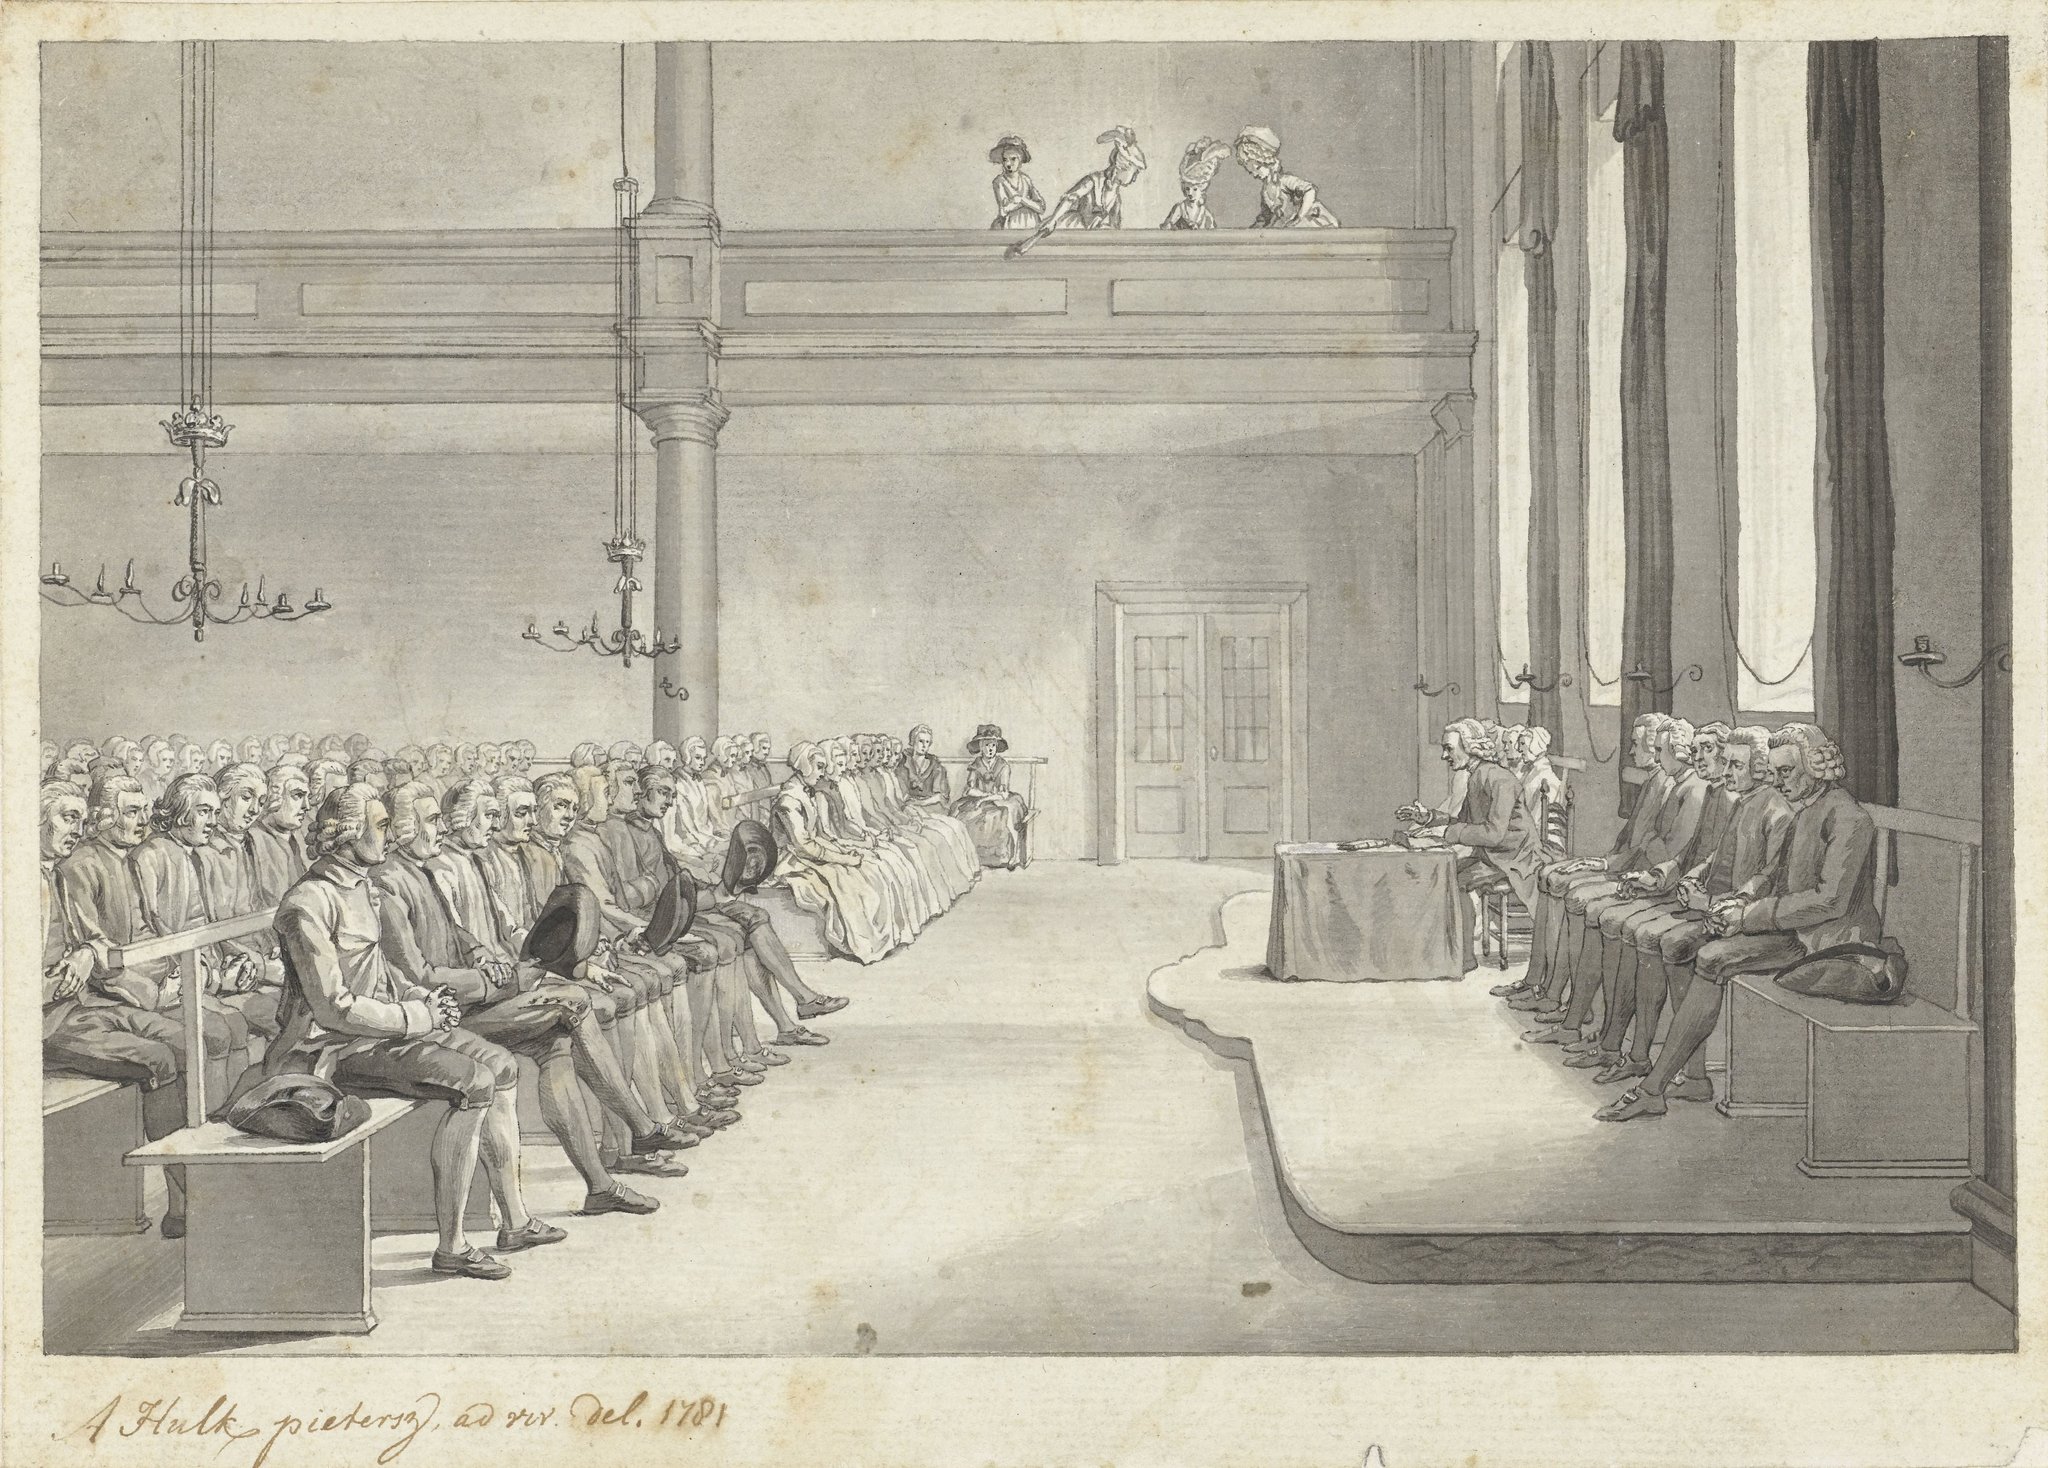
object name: design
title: Broedergemeente te Zeist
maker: abraham pietersz. hulk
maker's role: draughtsman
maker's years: 1752-1809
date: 1781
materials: ink, paper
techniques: brush, pen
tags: sermon ~ protestant service, zeist